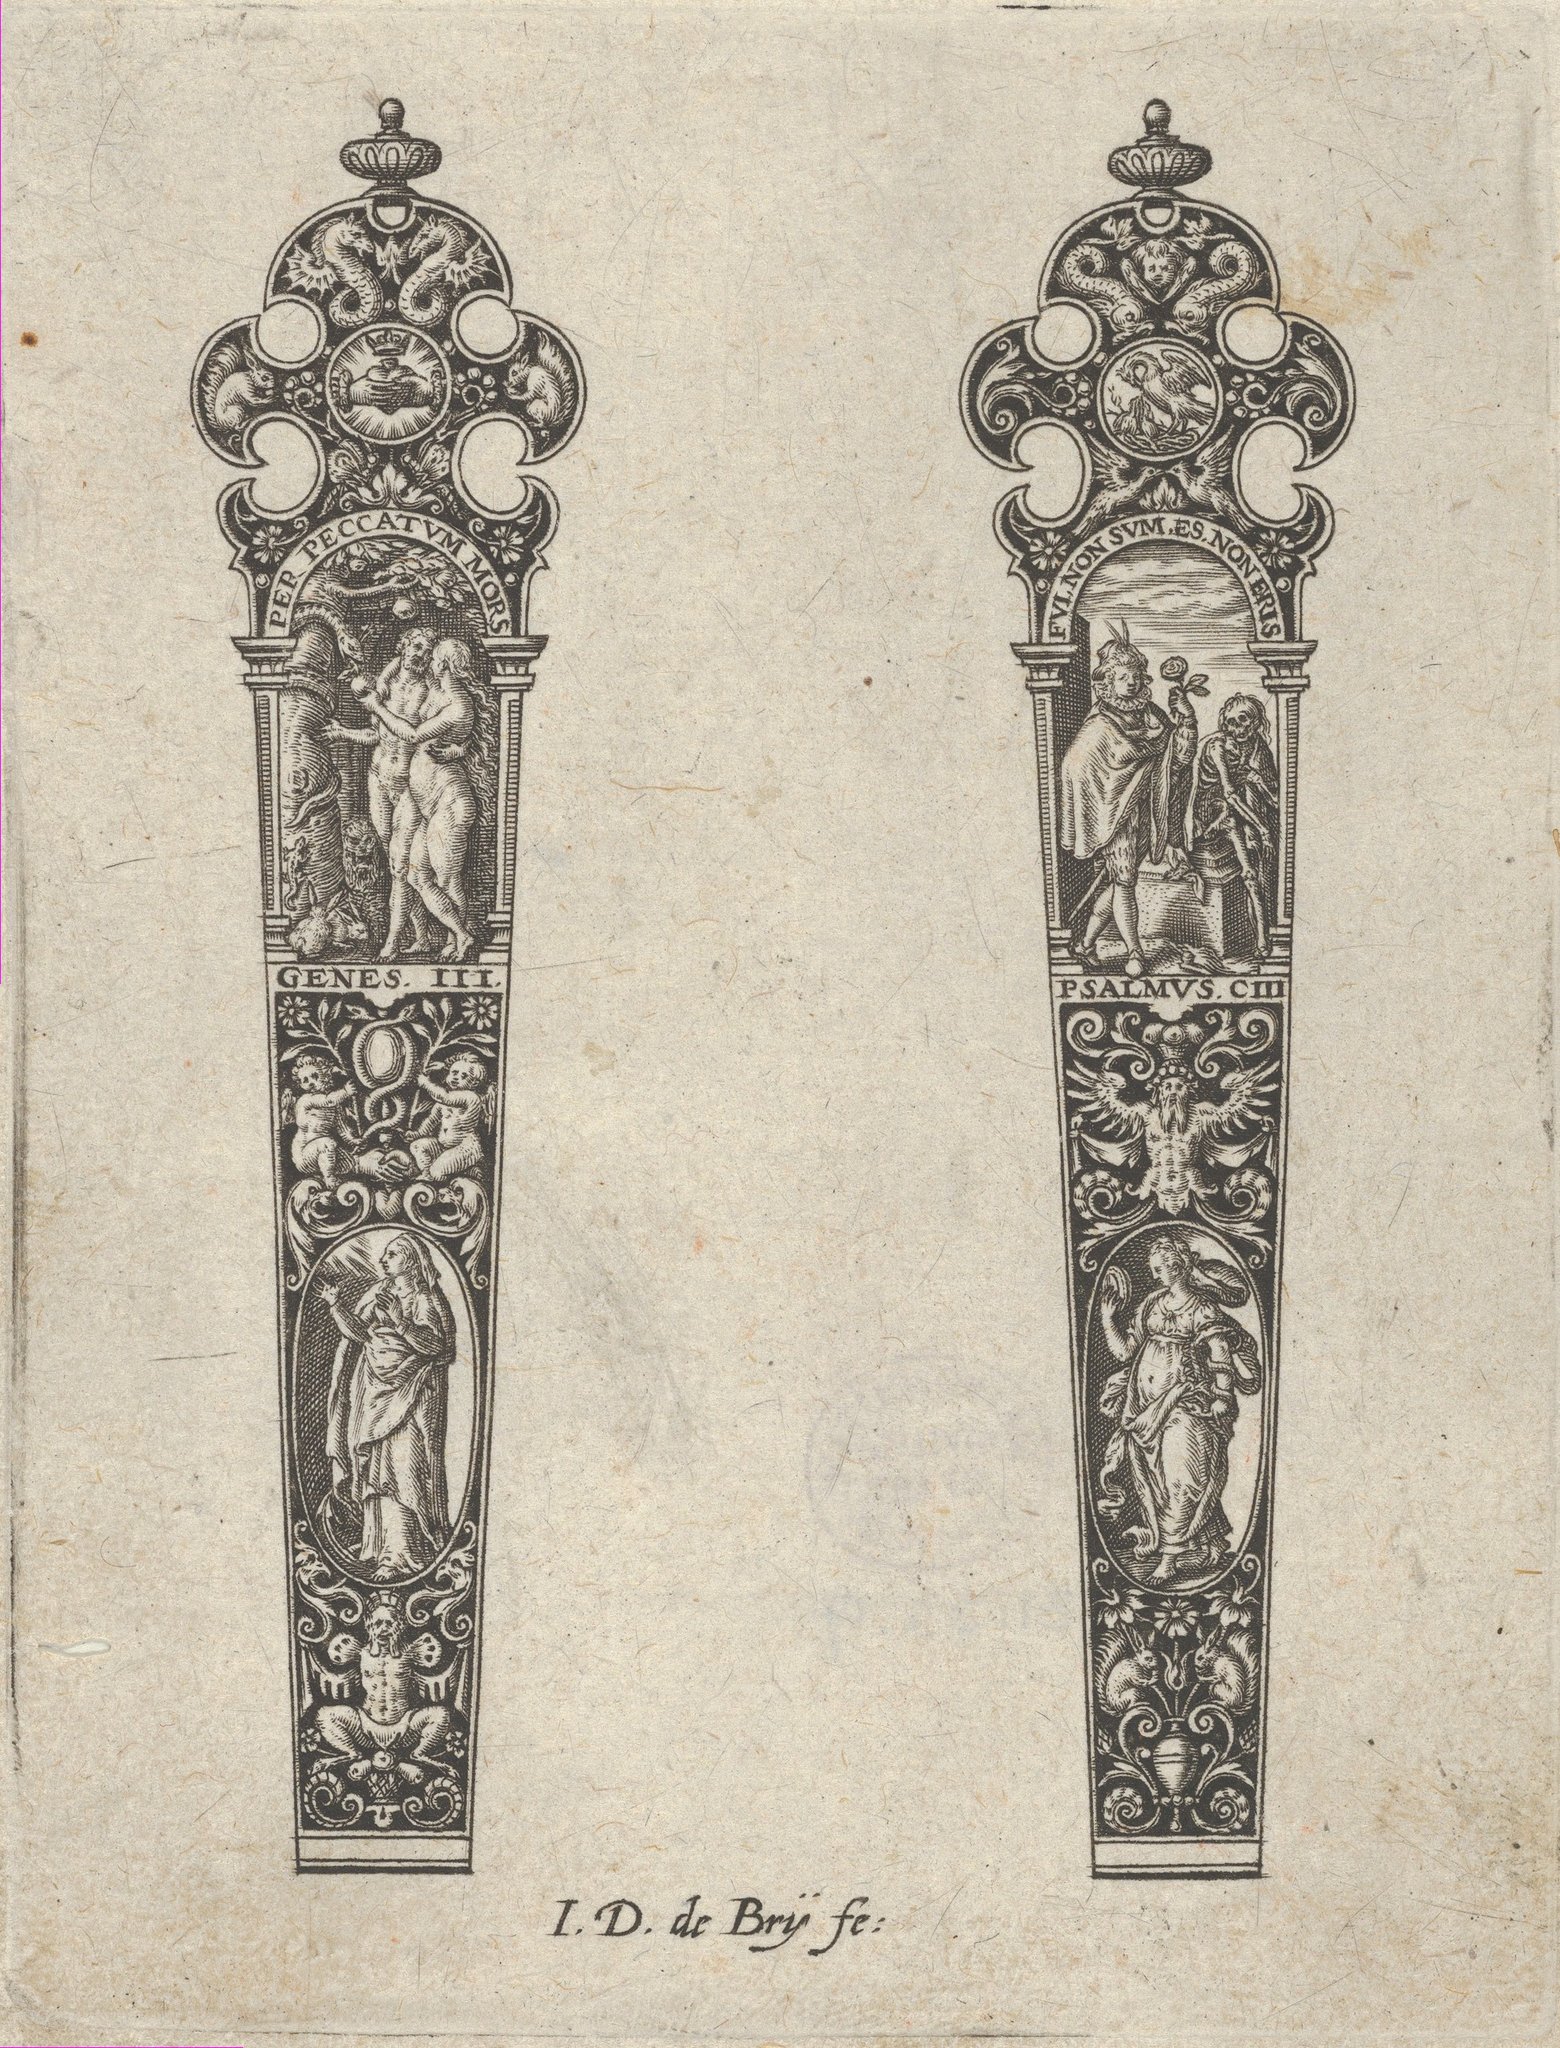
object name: print ornament architecture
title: Design for Knife Handles with the Temptation of Adam and Eve and a Memento Mori Scene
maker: johann theodor de bry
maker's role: artist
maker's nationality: netherlandish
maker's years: 1561-1623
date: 1580-1600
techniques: embroidery, engraving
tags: hilts,skeletons,snakes,adam,eve